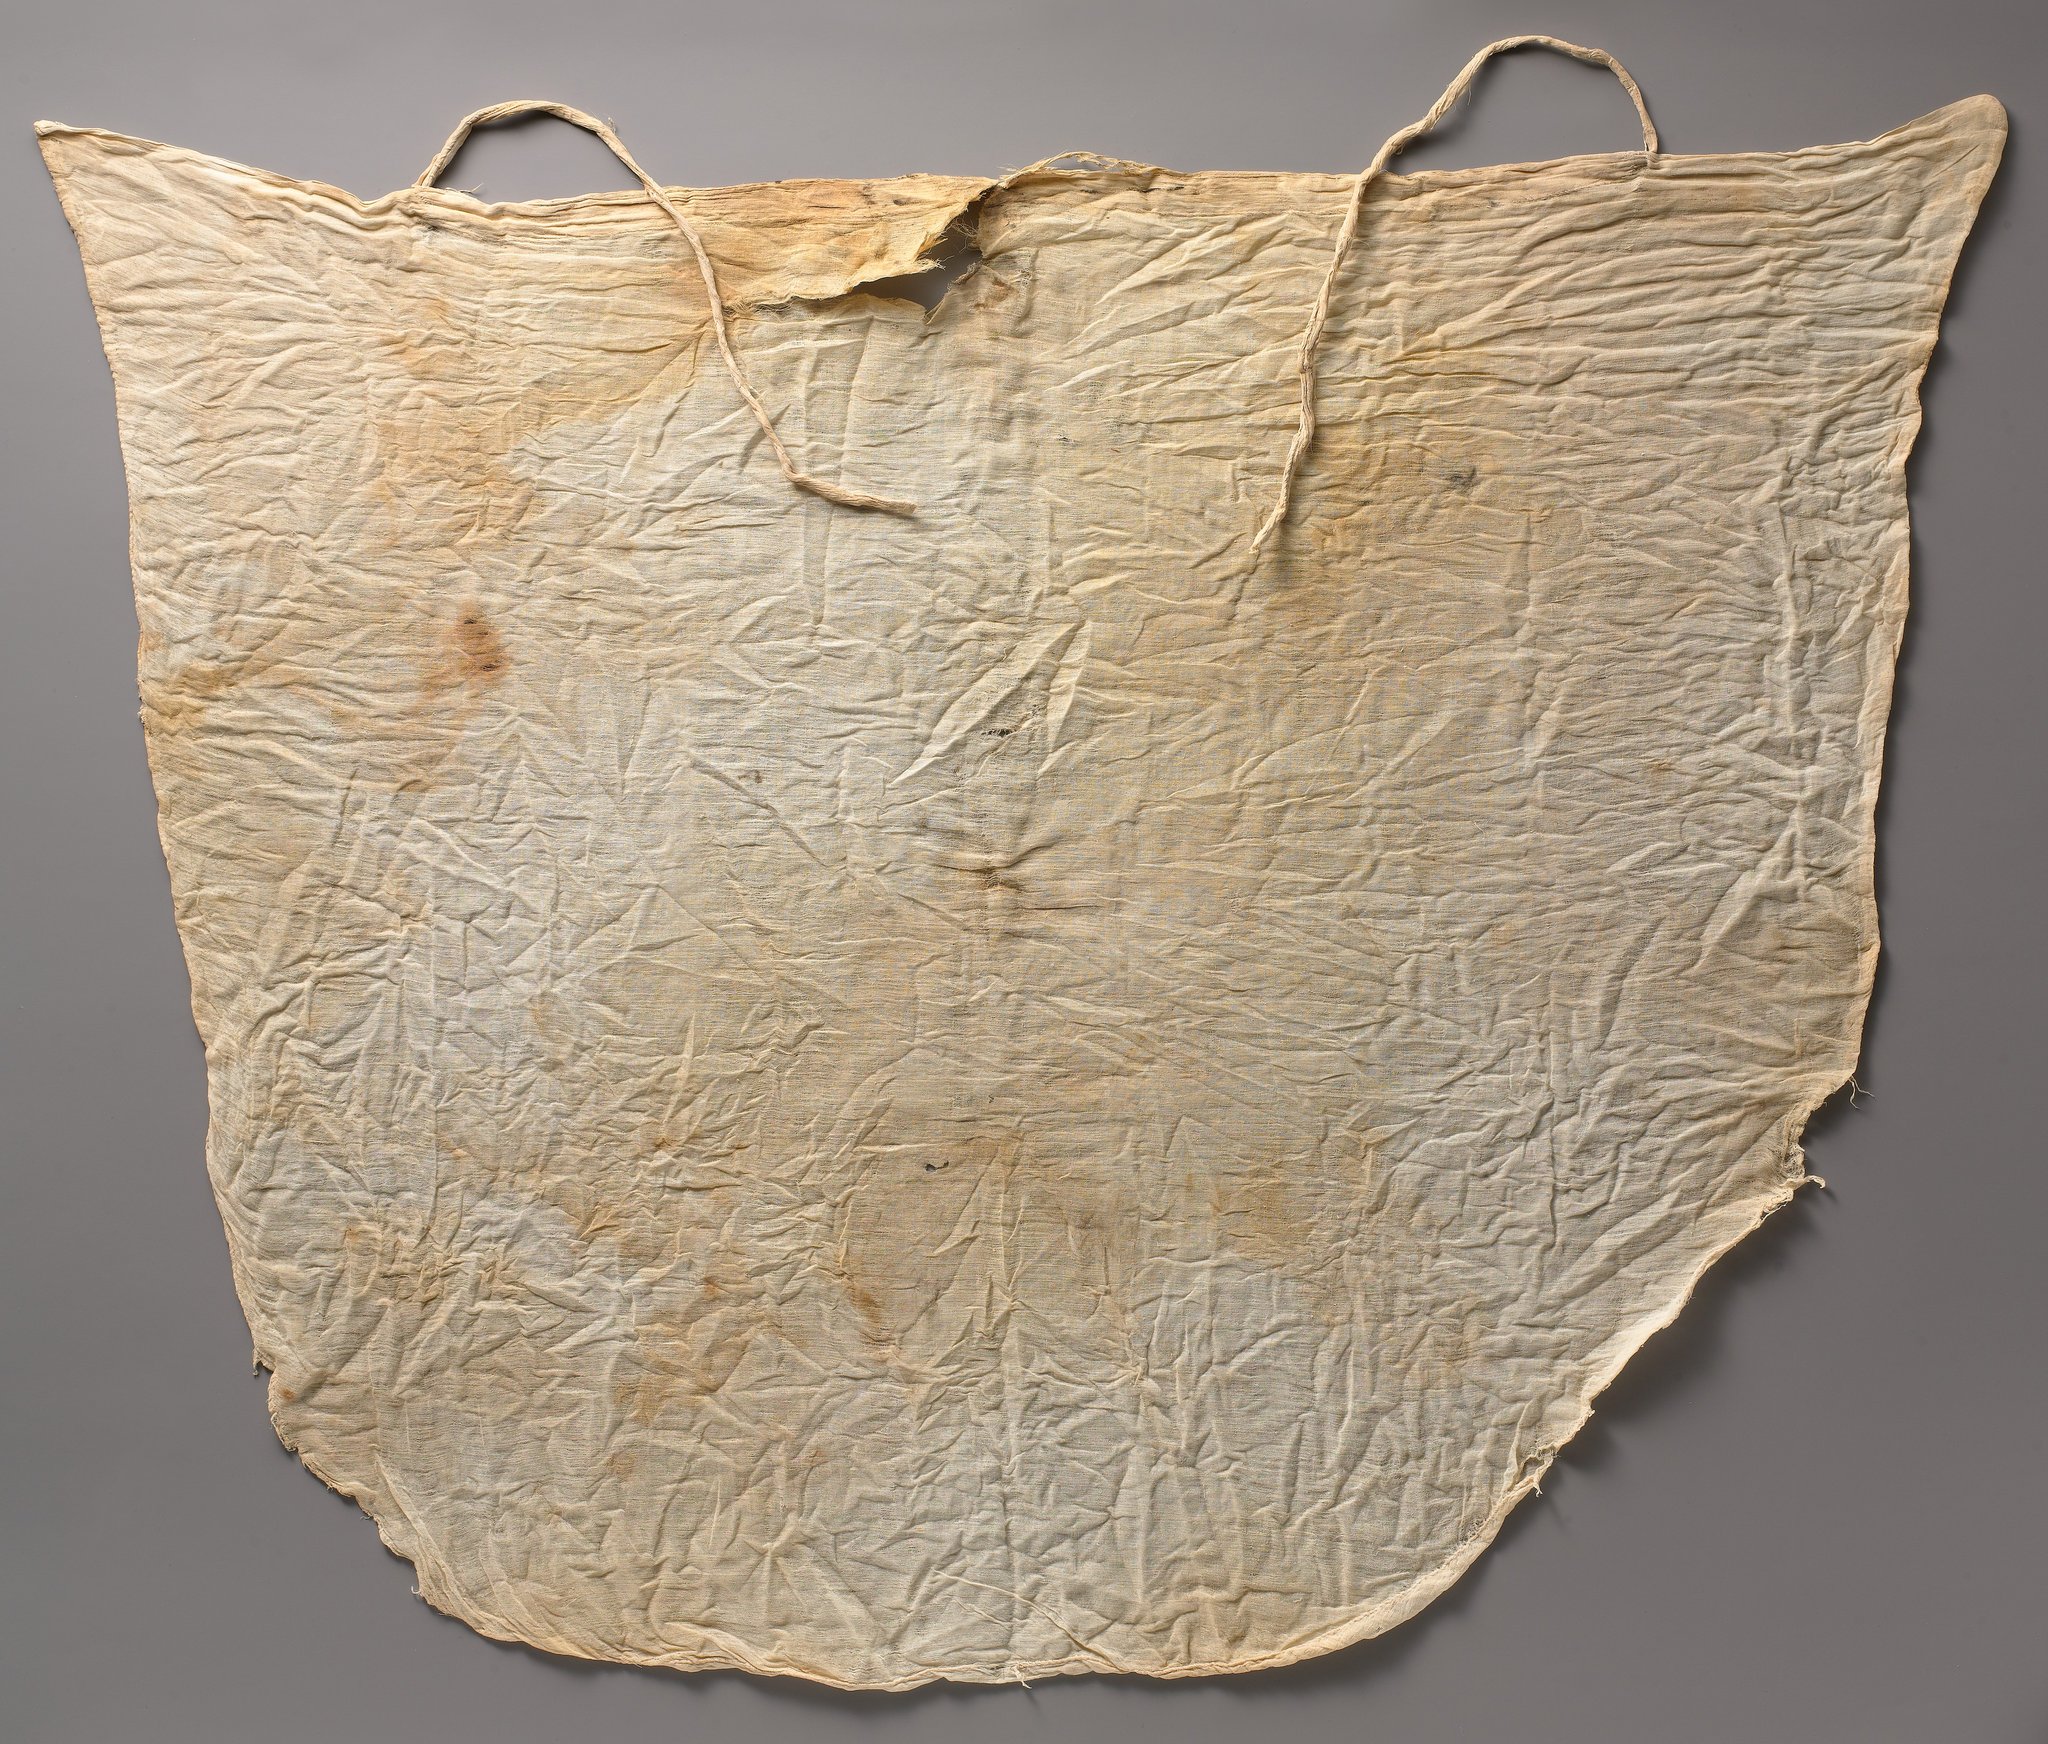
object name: kerchief, tutankhamun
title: Kerchief from Tutankhamun's Embalming Cache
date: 1336-1327 BCE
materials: linen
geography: egypt